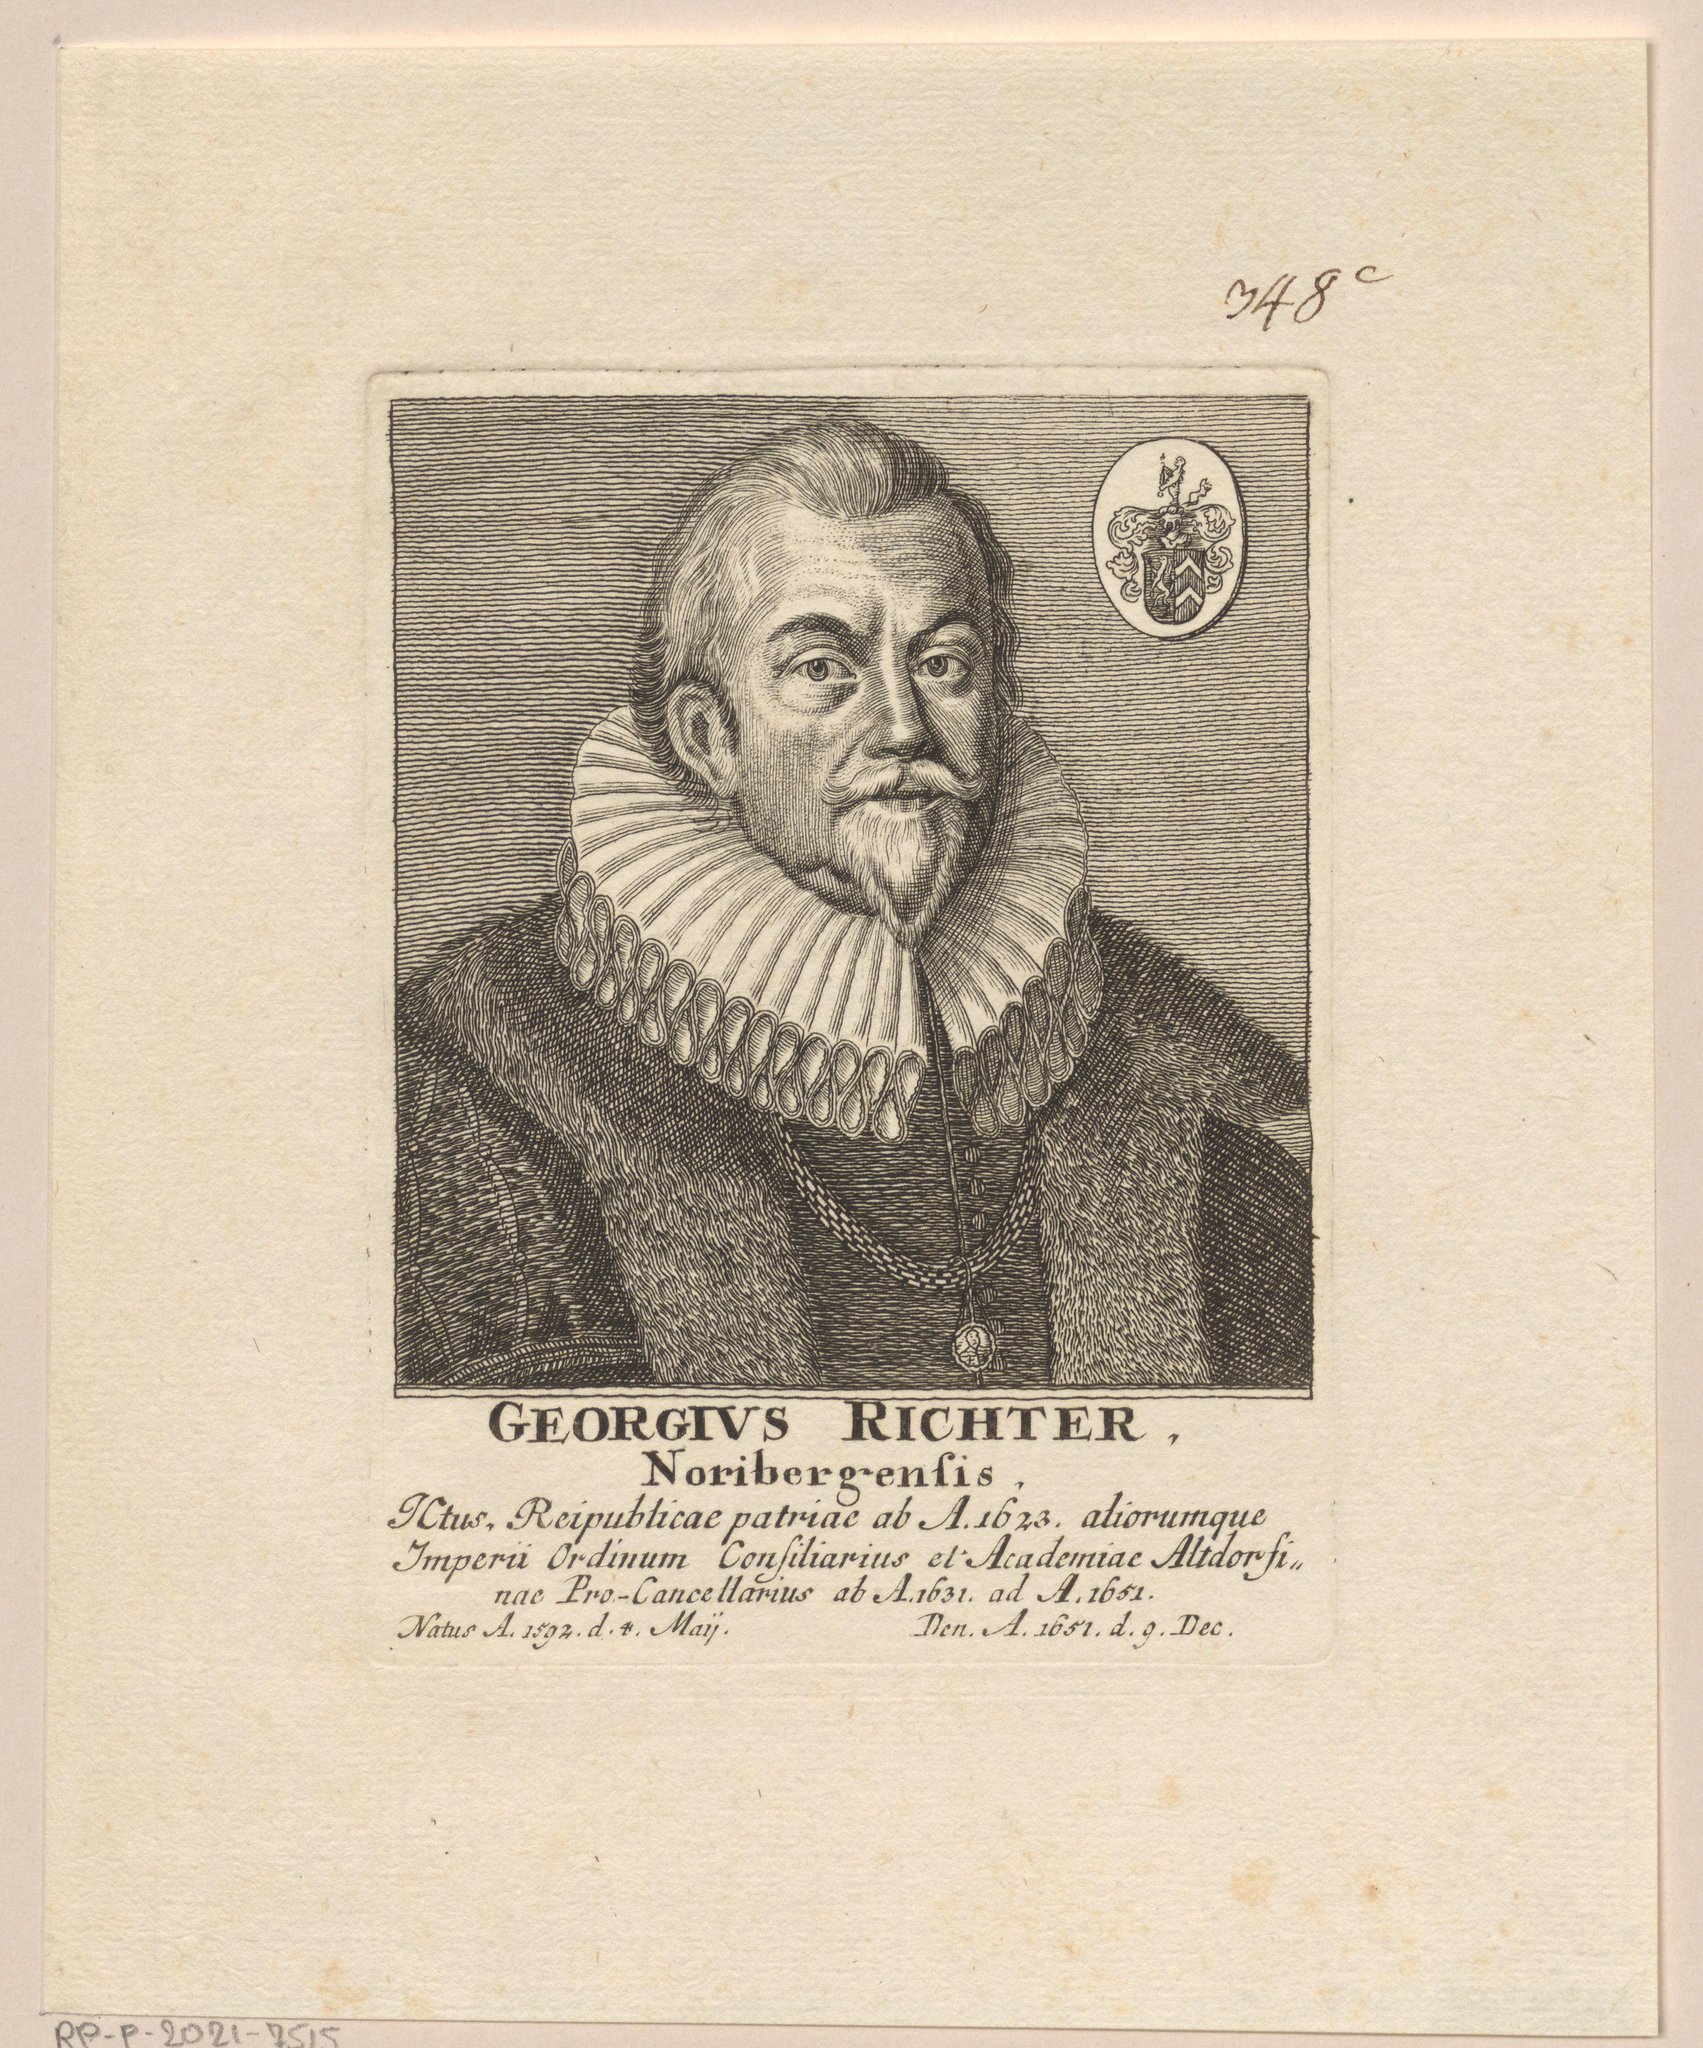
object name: print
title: Portret van Georg Richter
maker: Anonymous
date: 1723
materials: paper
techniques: engraving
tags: historical persons, armorial bearing, heraldry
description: Prent mogelijk uit: Rothscholtz, Friedrich. Icones consiliariorum de illustri republica Noribergensi (...). Neurenberg en Altdorf: erven Johann Daniel Tauber, 1723.